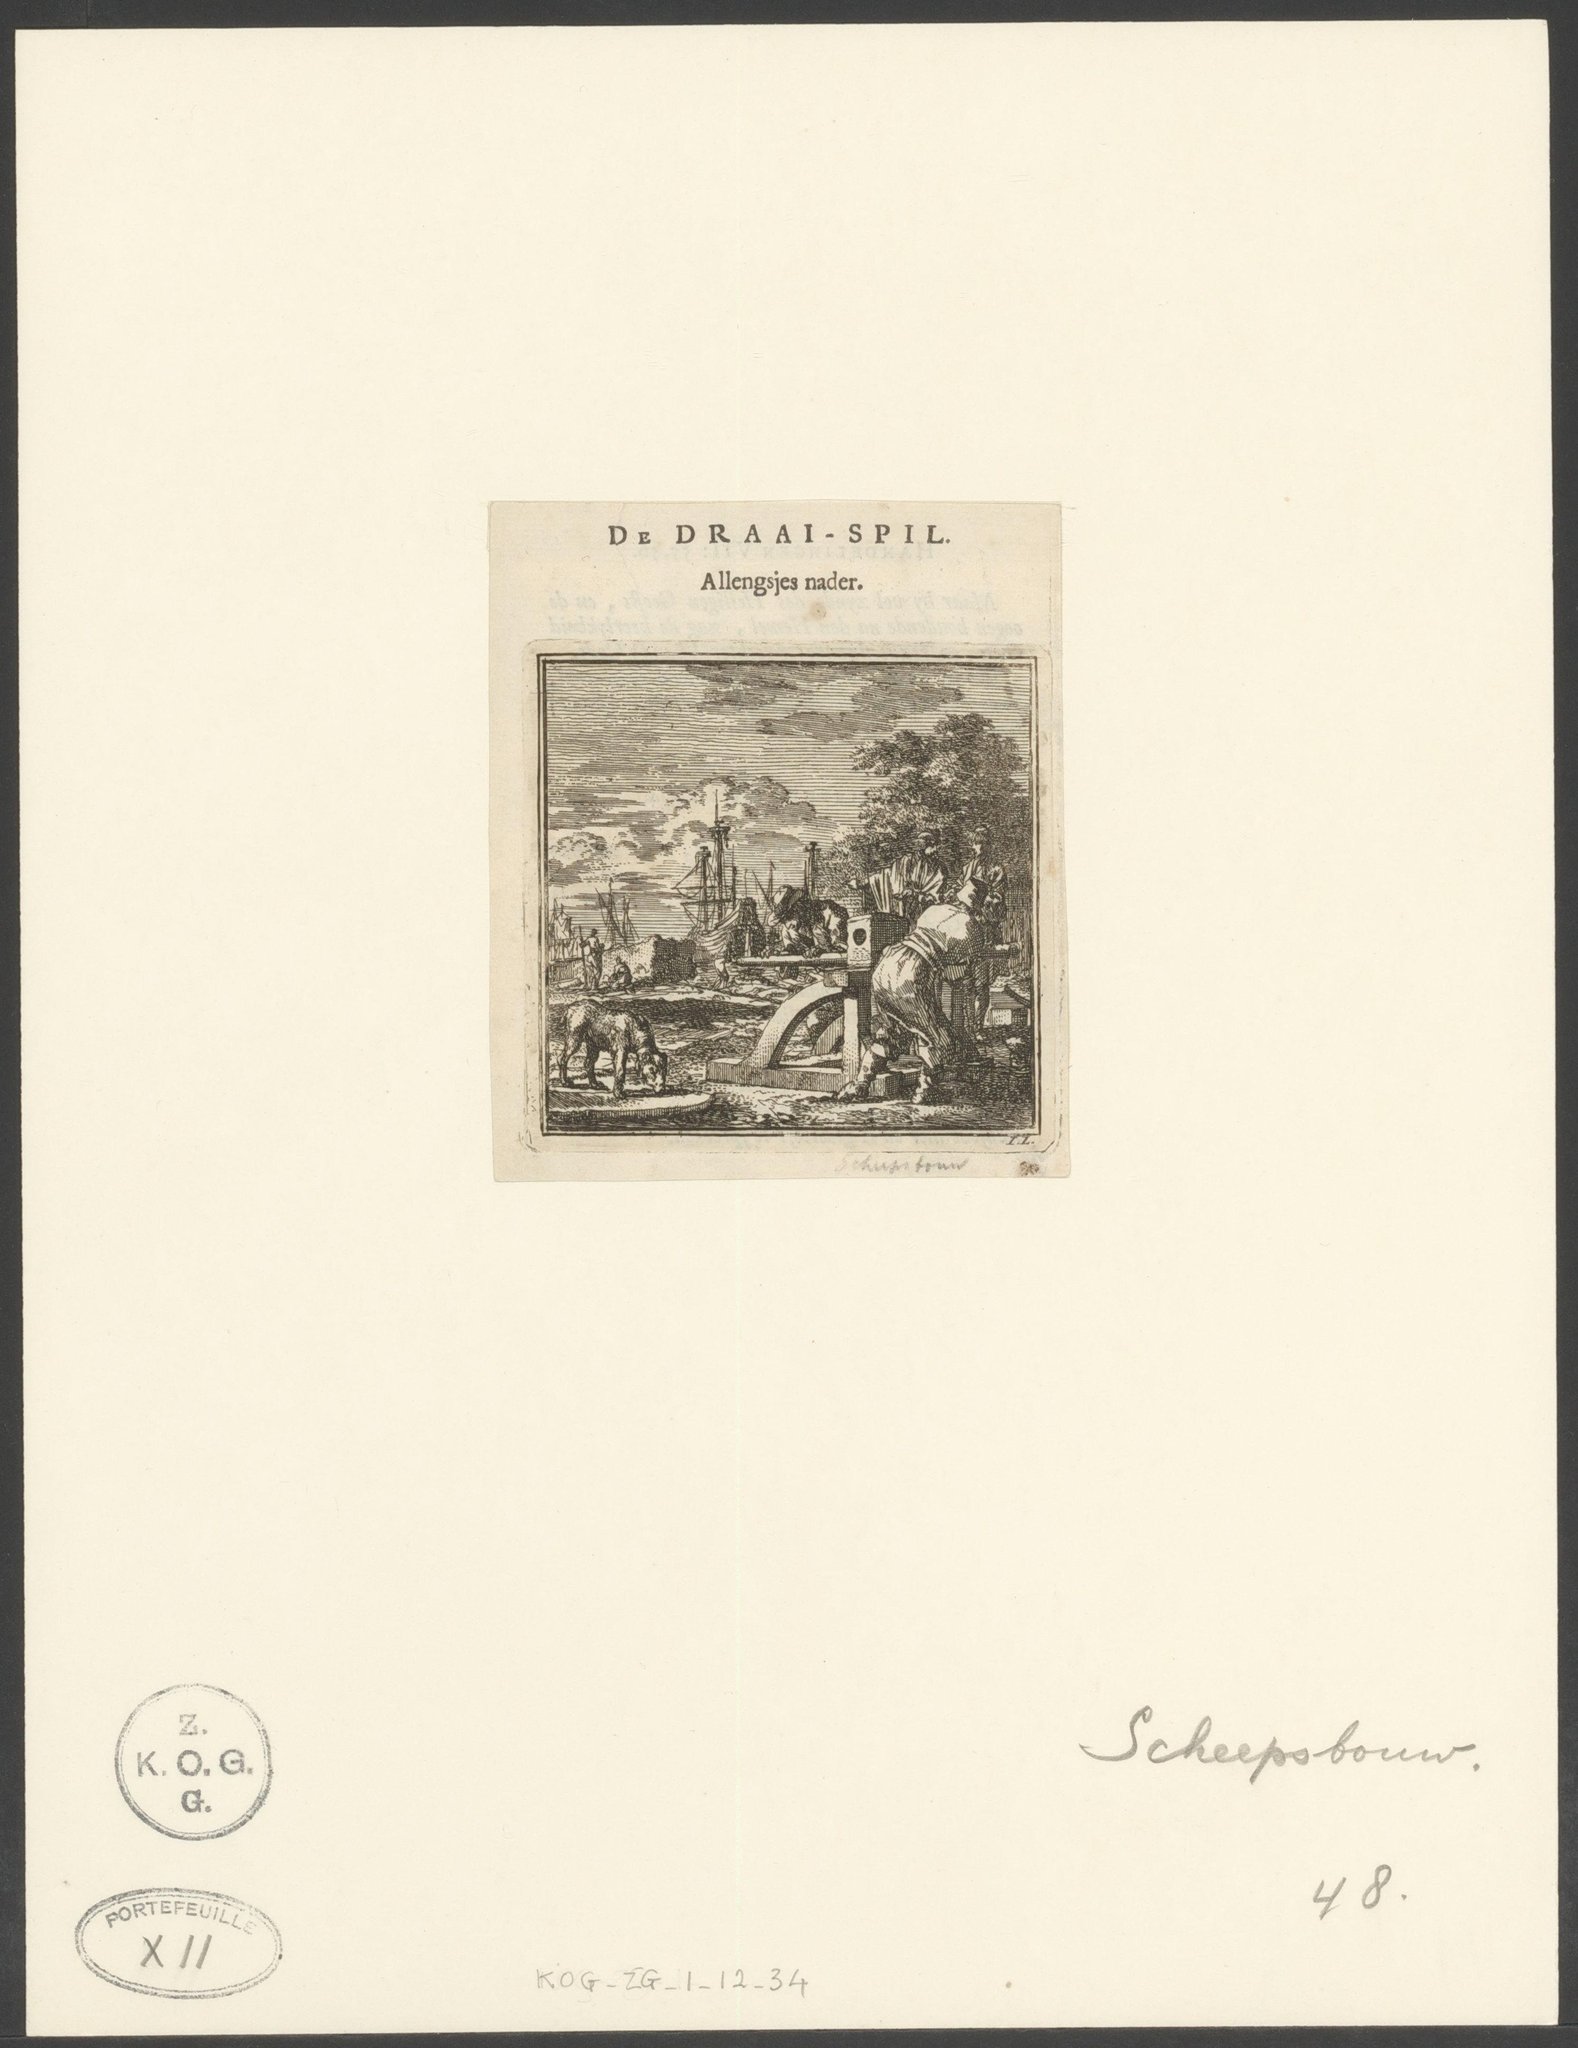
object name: book illustration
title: Twee mannen werken met een windas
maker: jan luyken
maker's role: draughtsman, print maker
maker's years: 1649-1712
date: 1711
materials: paper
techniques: etching, letterpress printing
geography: amsterdam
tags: tools, aids, implements ~ crafts and industries: windlass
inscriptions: collector's mark: Lugt 1641, stamp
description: Prent uit: Luyken, Jan. De Bykorf des Gemoeds. Amsterdam: Pieter Arentsz. II (wed.) en Cornelis van der Sys, 1711, p. 374.